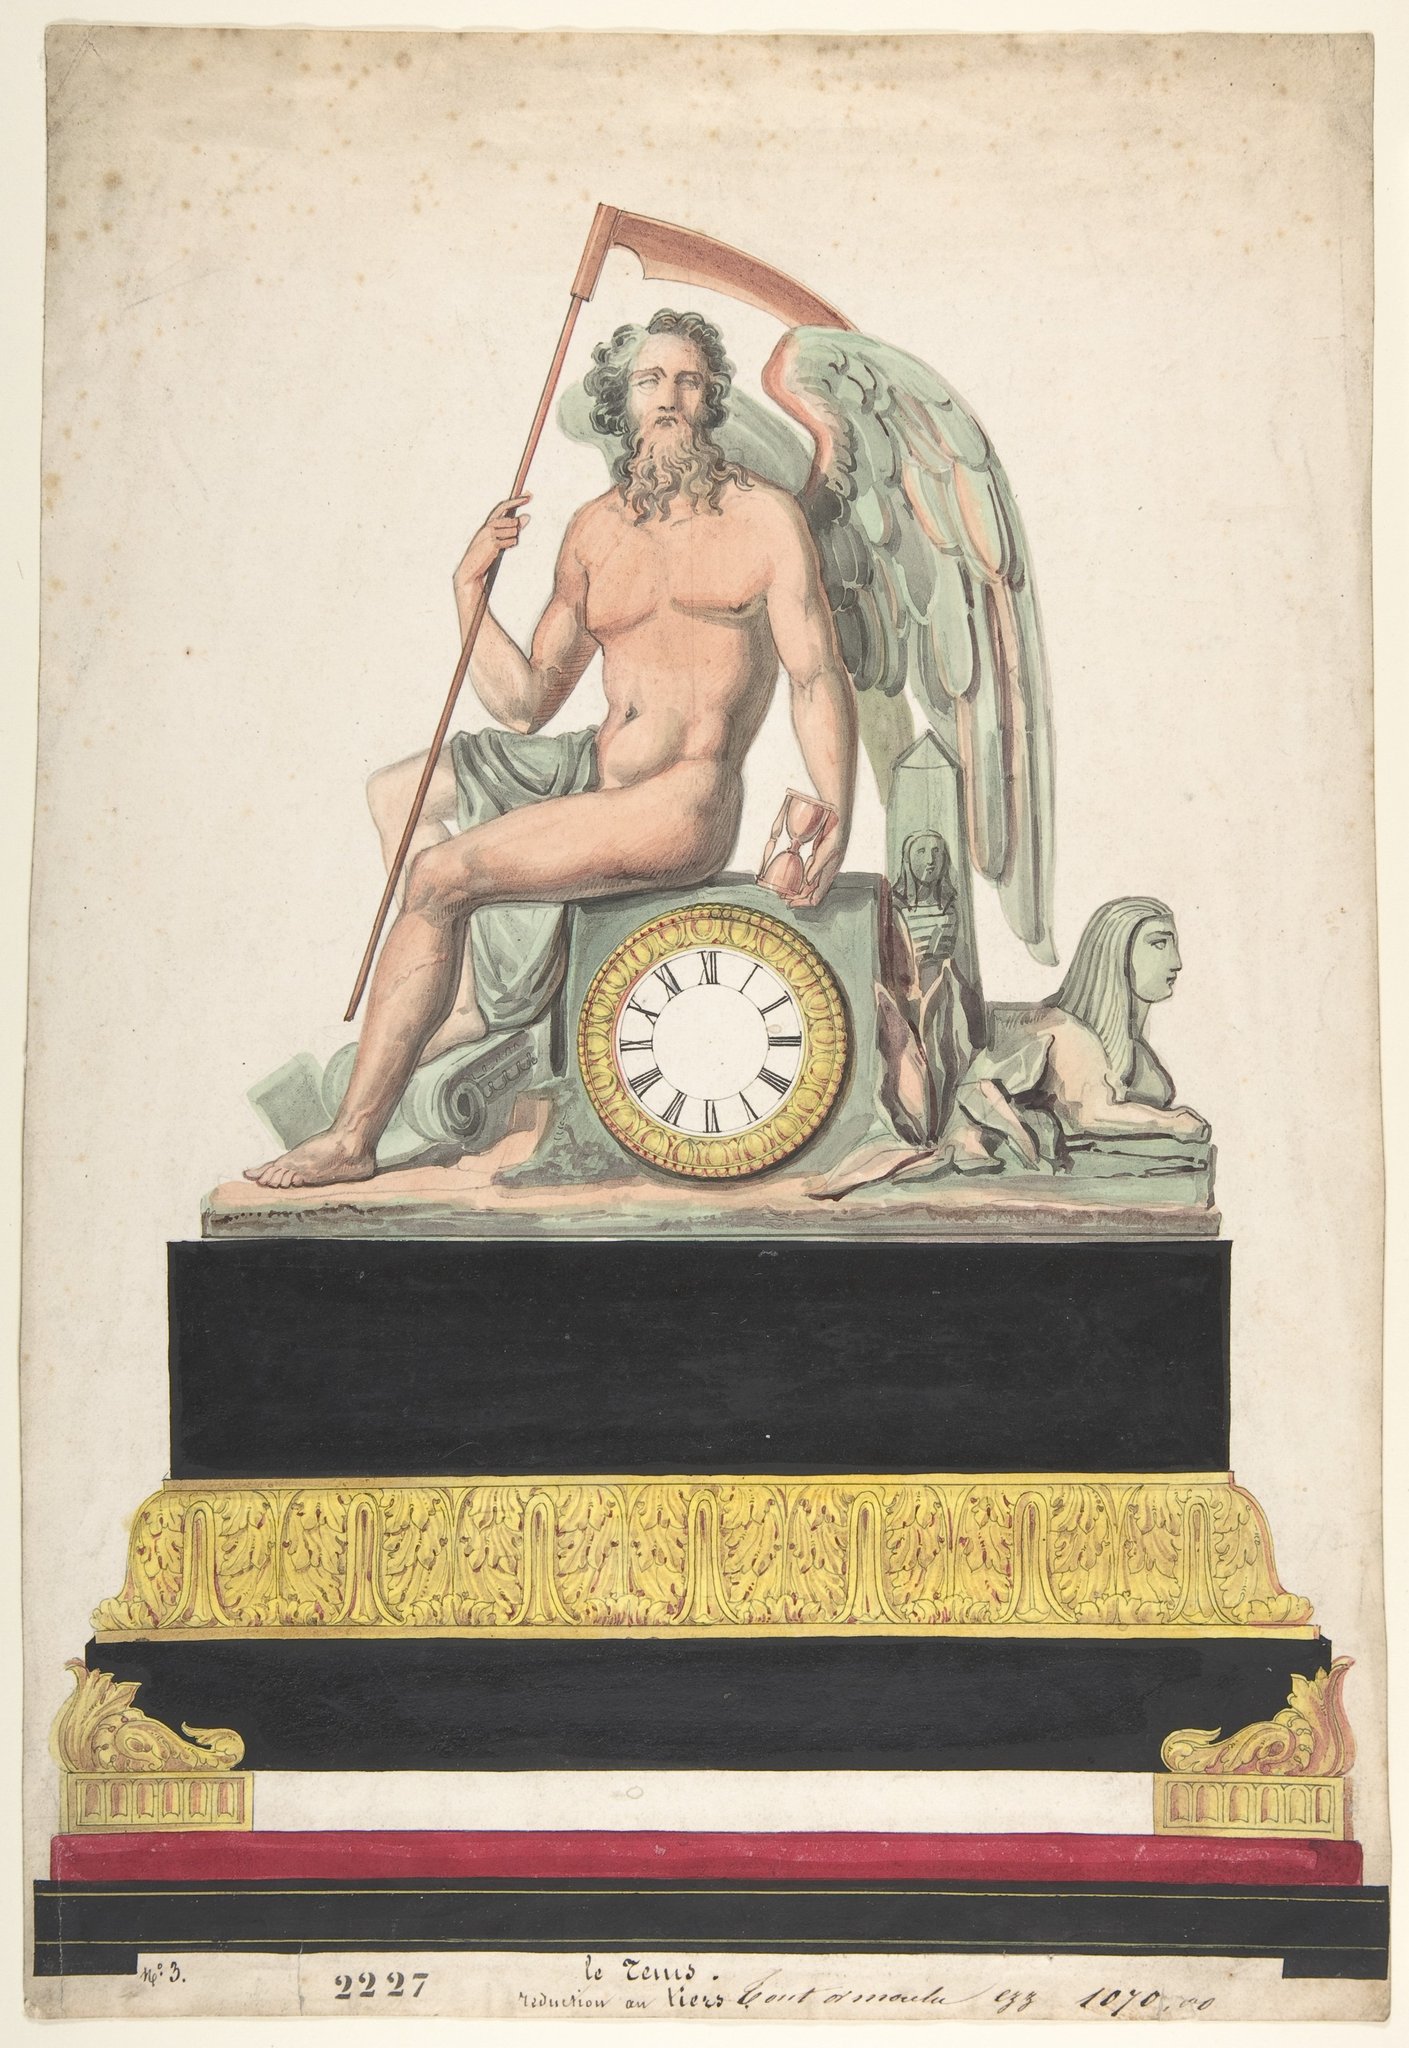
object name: drawing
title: Design for Clock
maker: anonymous, french, 19th century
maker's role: artist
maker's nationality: french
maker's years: 1800-1900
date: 1801-1900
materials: gouache, graphite, ink, watercolor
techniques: pen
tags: sphinx,clocks